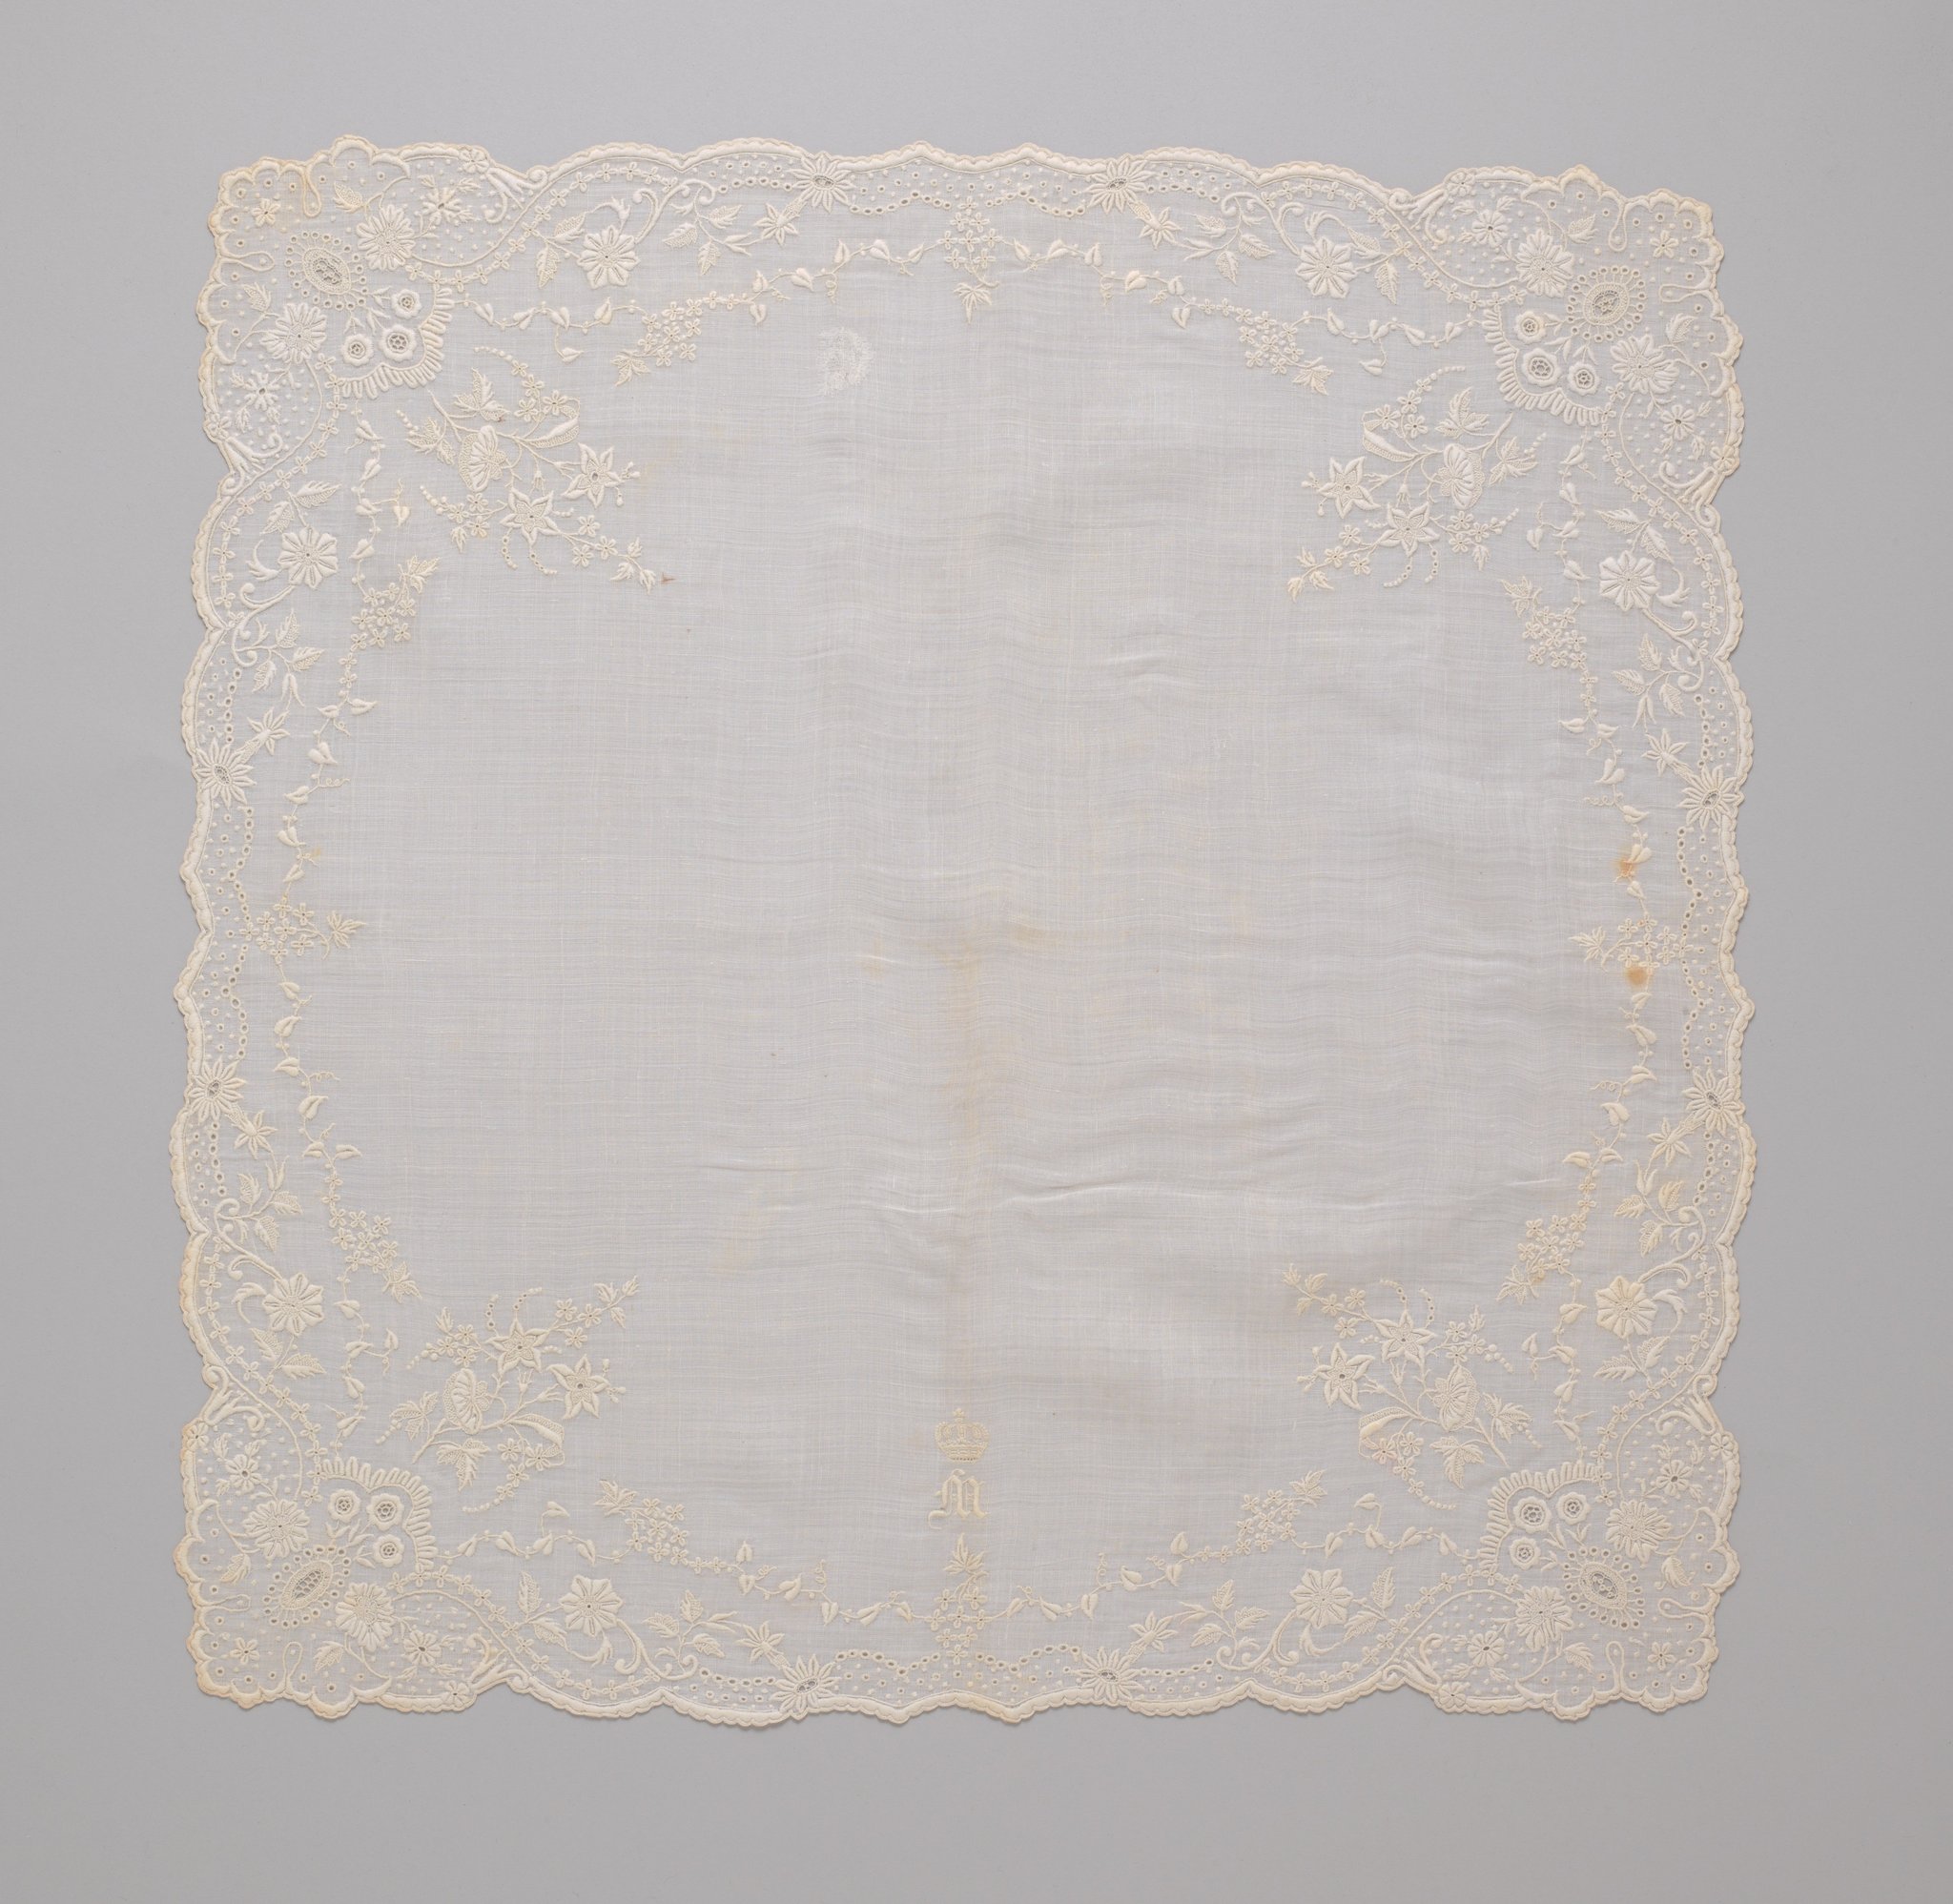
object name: handkerchief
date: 1840-1880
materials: linen, silk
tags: flowers